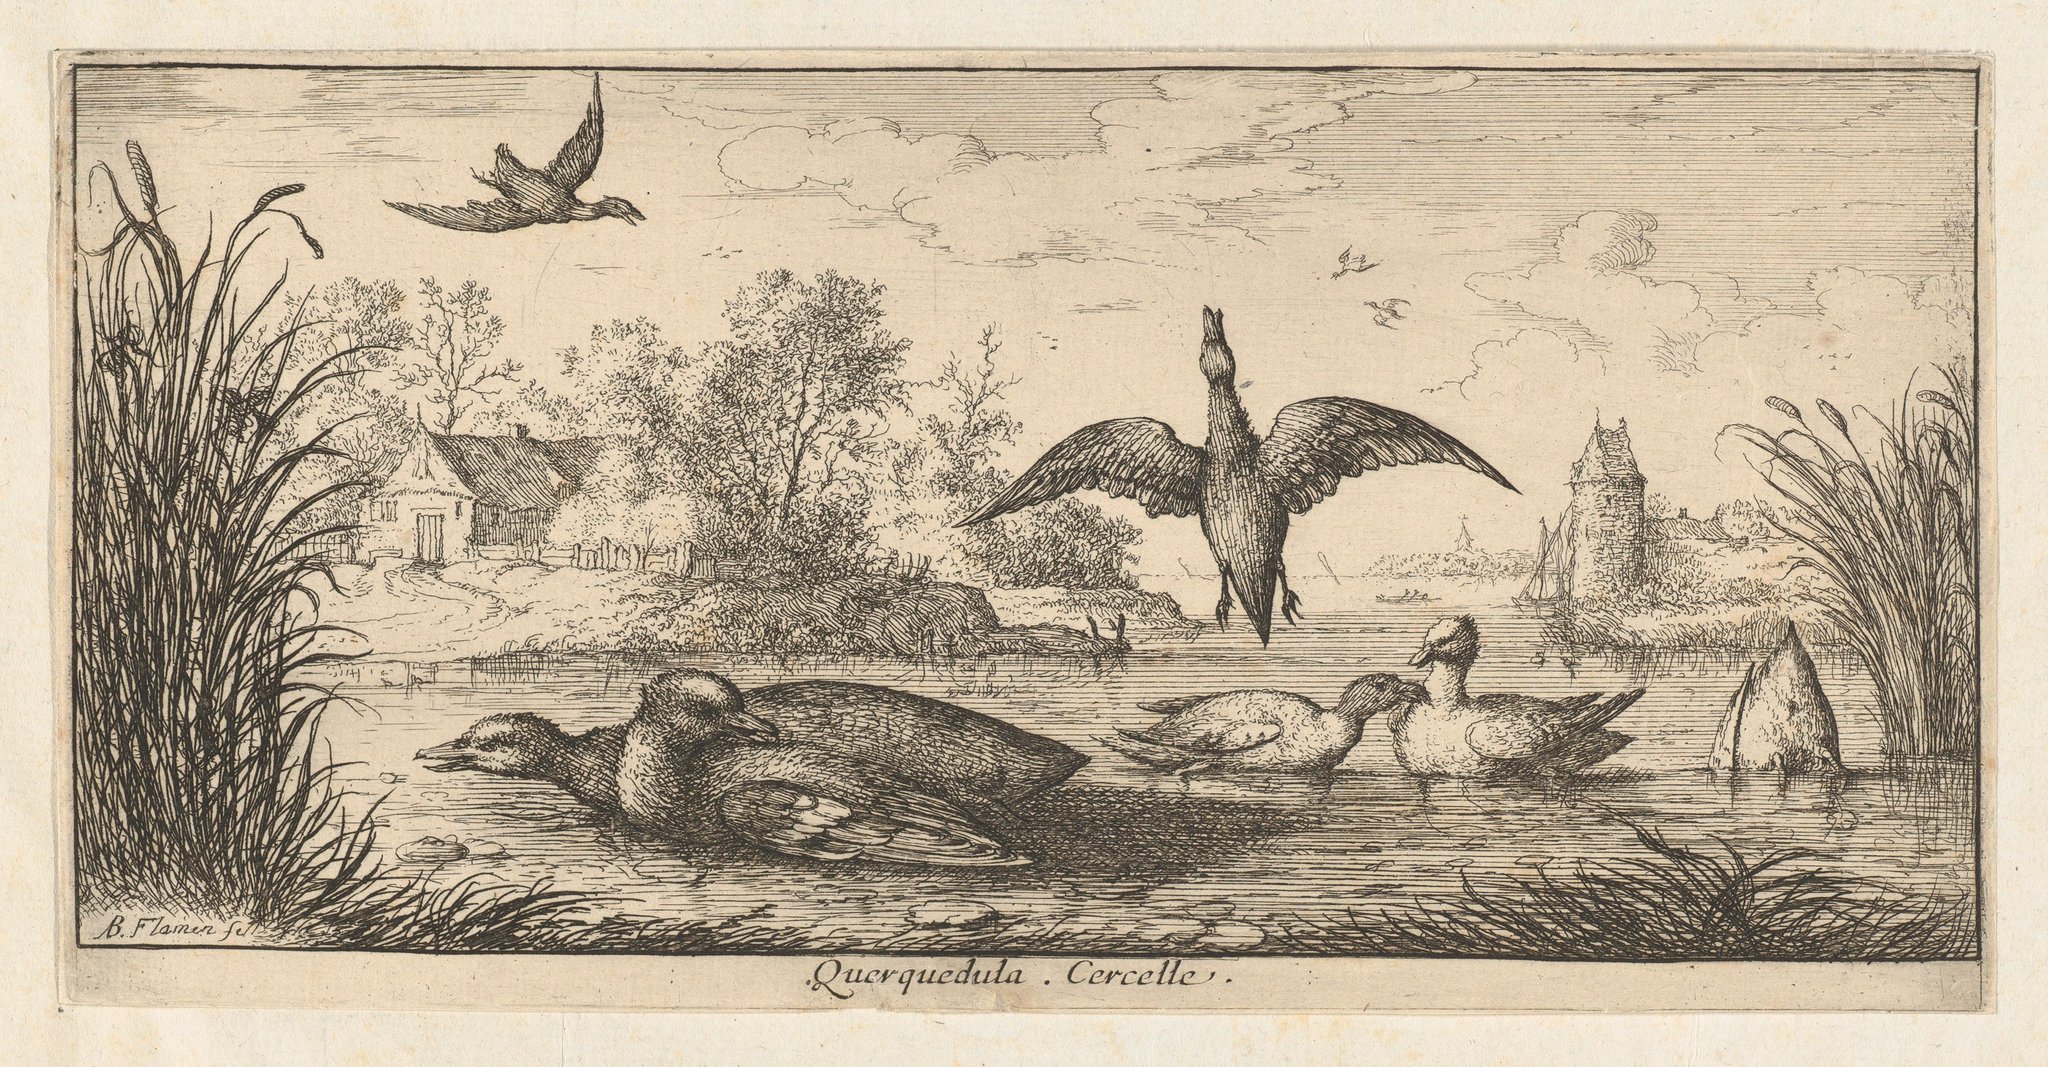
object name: print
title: Querquedula, Cercelle (The Teal), from "Livre d'Oyseaux" (Book of Birds)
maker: albert flamen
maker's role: artist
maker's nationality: flemish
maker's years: 1615-1688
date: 1655-1660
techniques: etching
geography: france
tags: birds